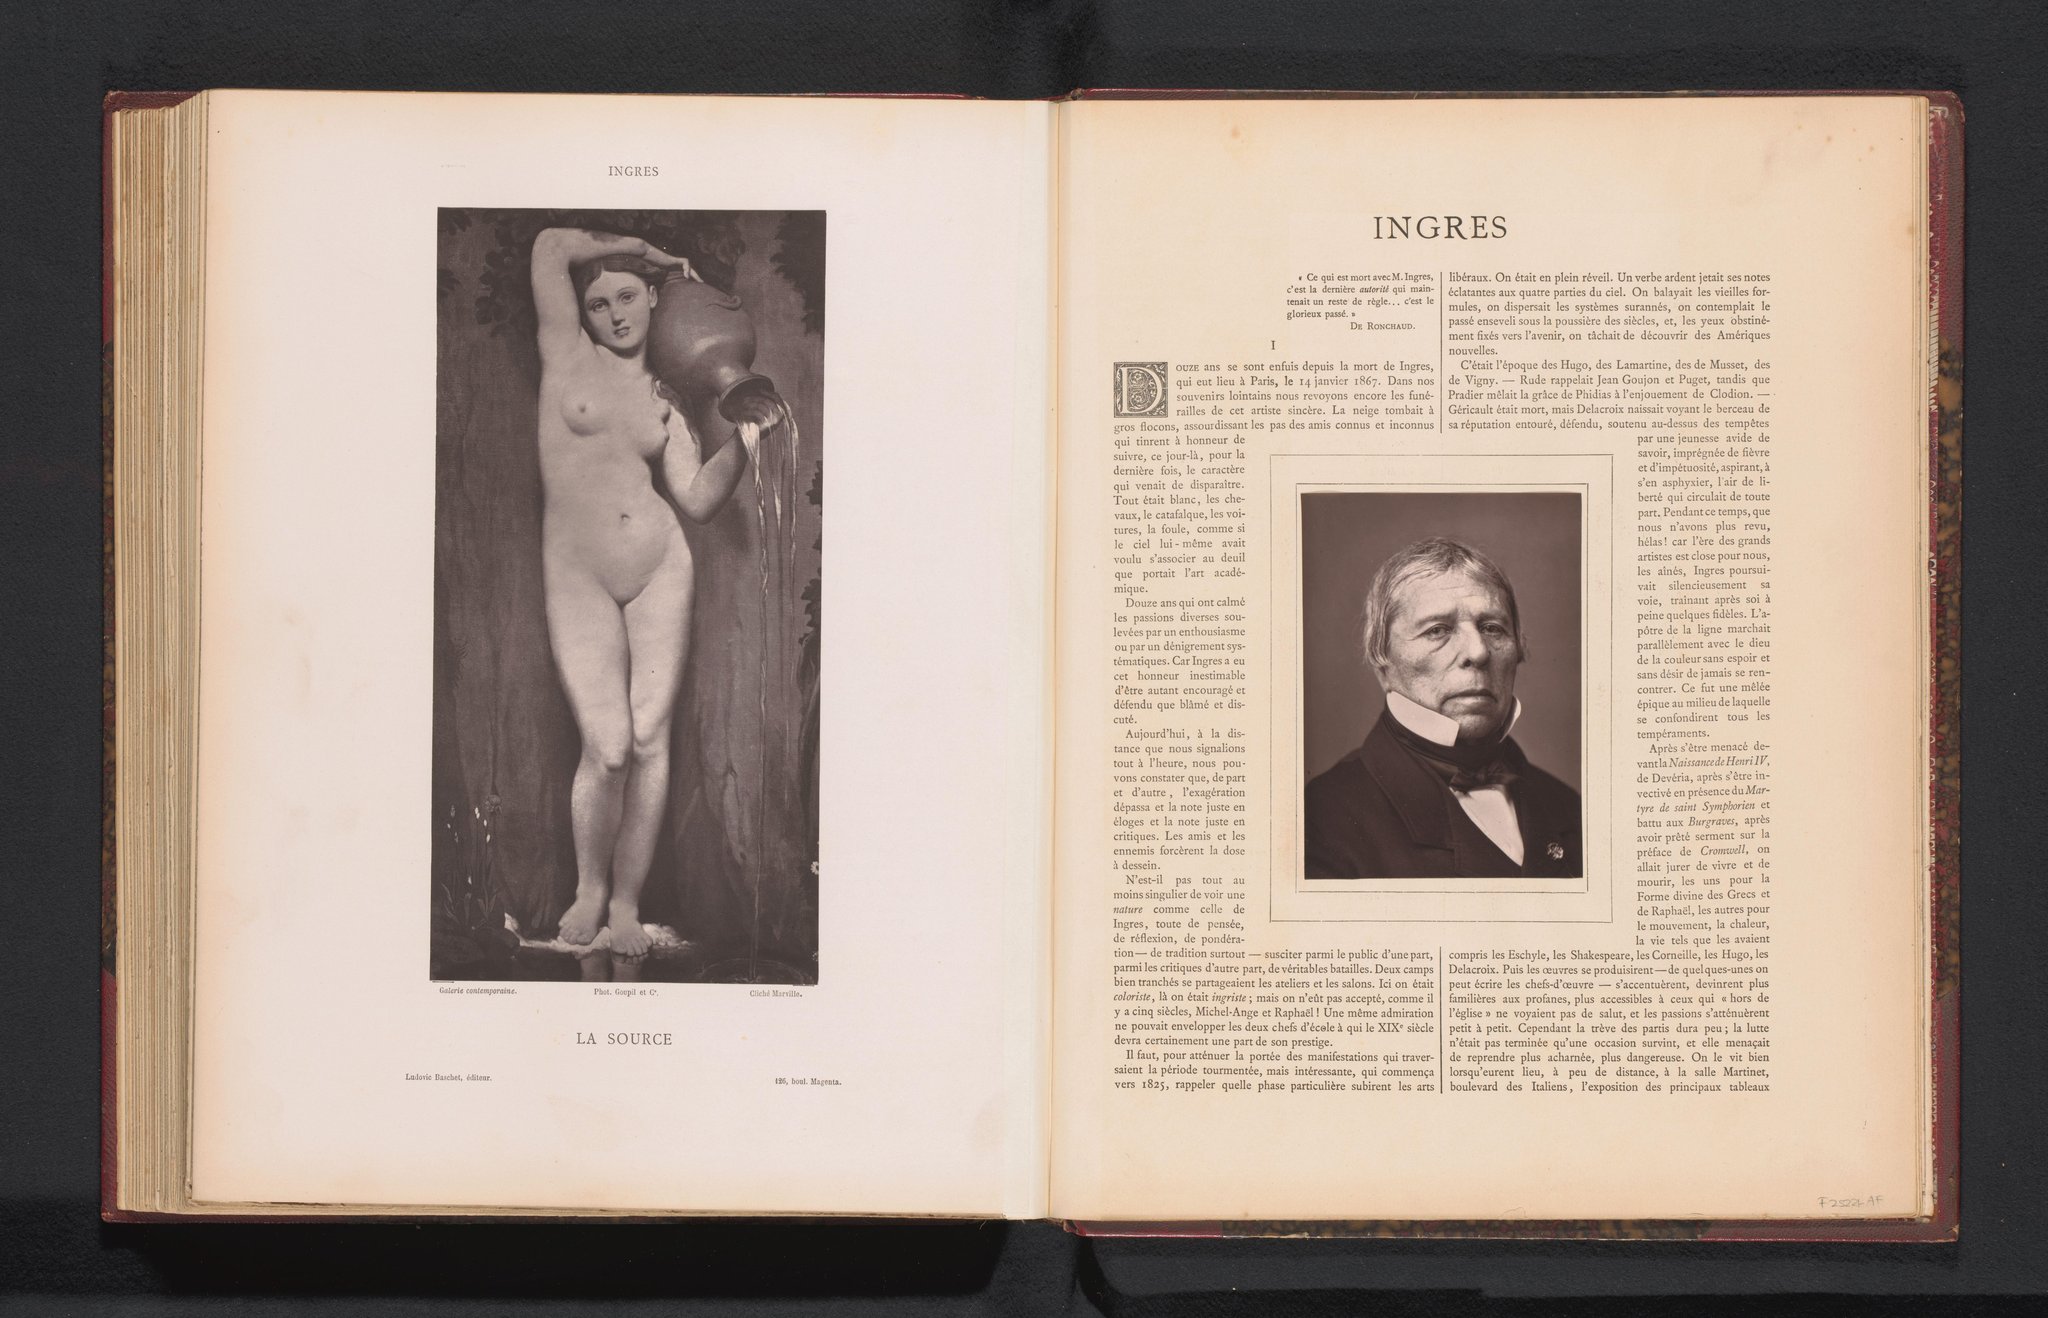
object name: photomechanical print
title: Reproductie van La source door Jean Auguste Dominique Ingres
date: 1873-1878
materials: paper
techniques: woodburytype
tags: 'décolleté', container of ceramics: jar, jug, pot, vase, painting, drawing and the graphic arts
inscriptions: inscription: ‘Ingres/ Galerie Contemporaine/ Ludovic Baschet, éditeur./ 126 boul. Magenta.’